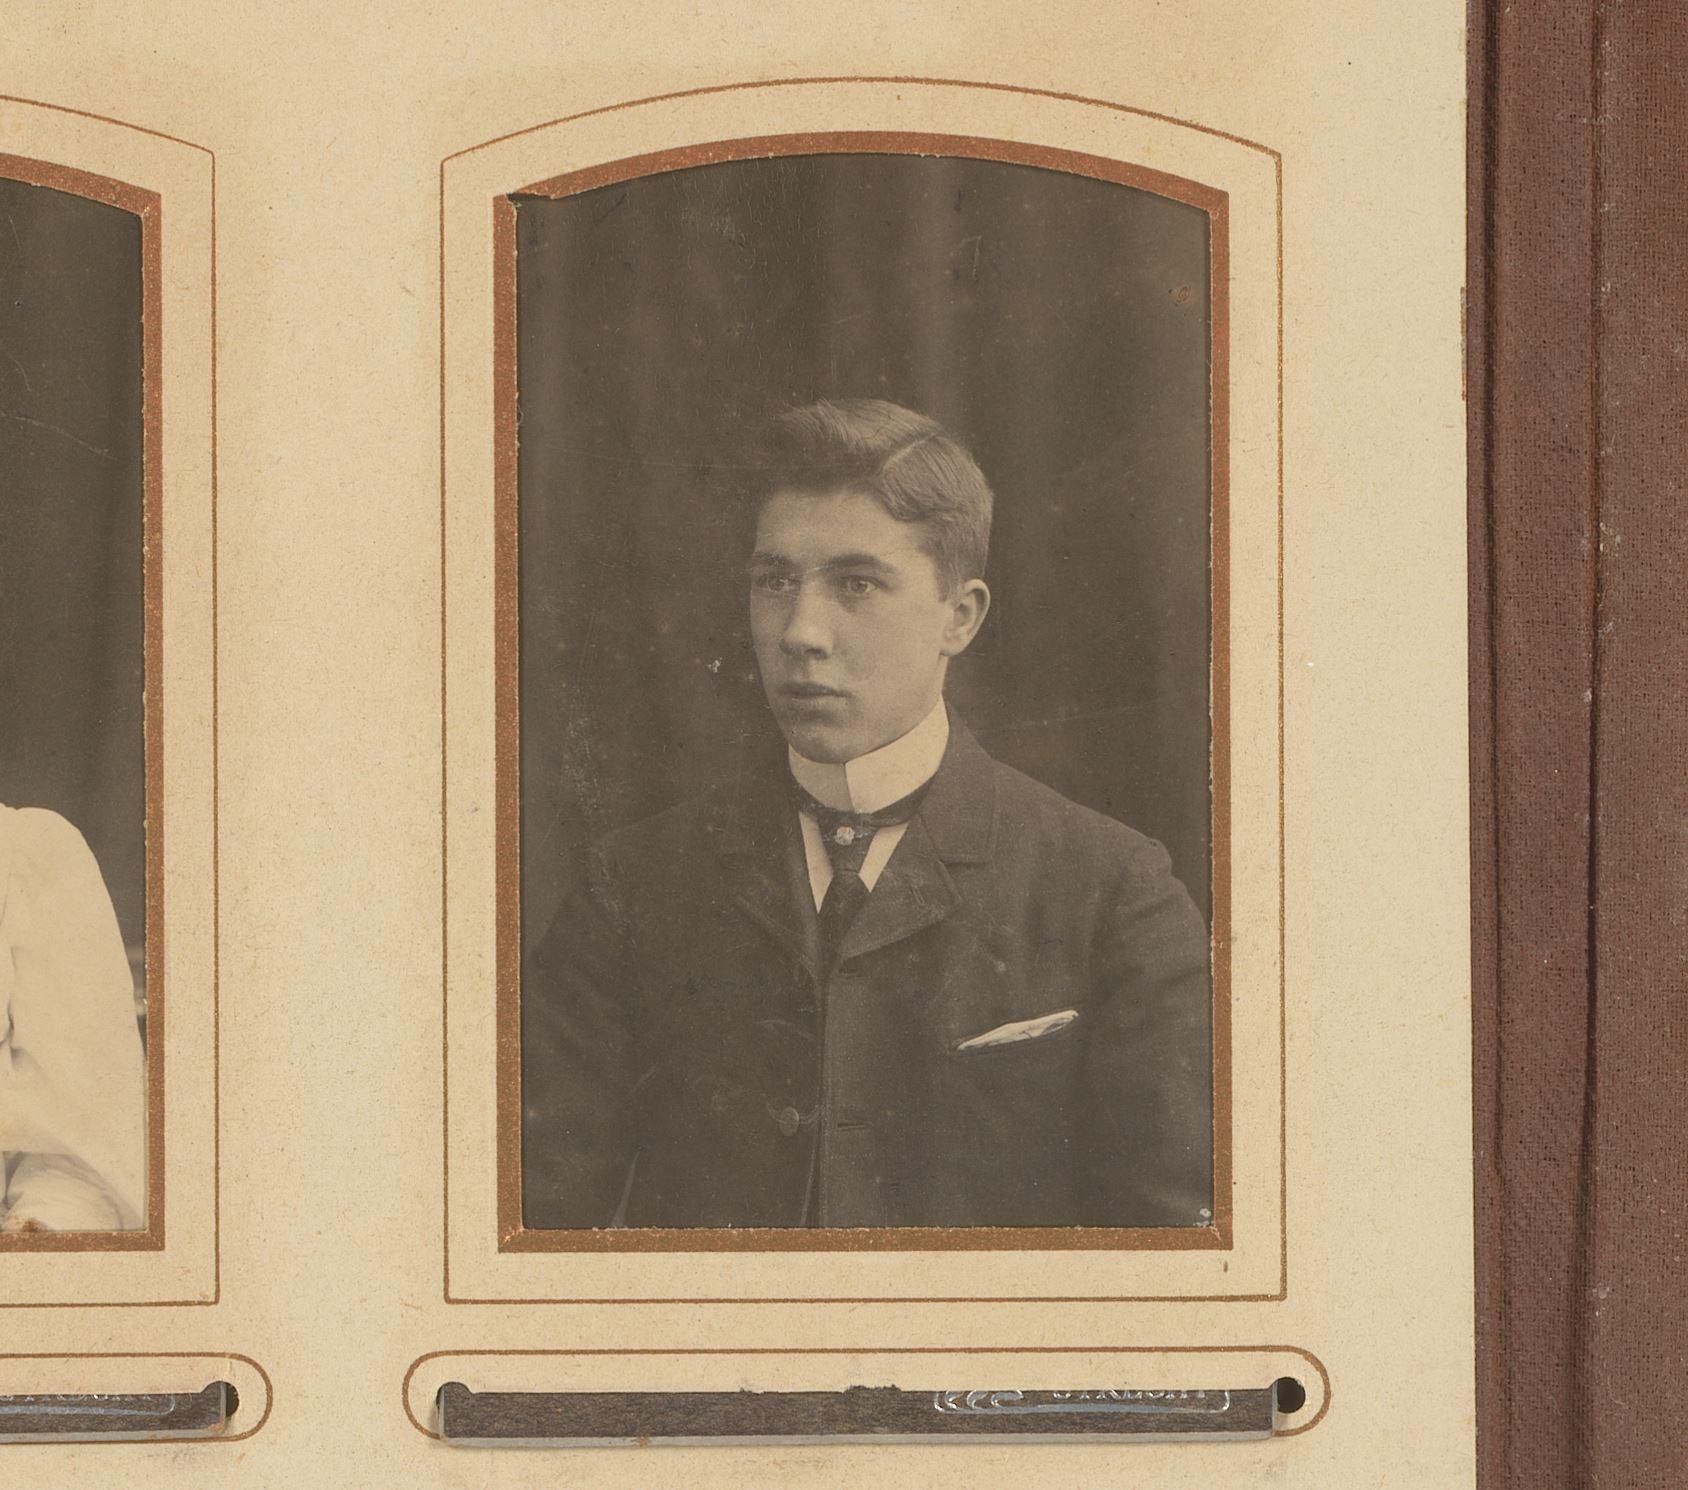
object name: carte de visite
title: Portret van een jongeman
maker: anton cornelis thomann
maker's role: fotograaf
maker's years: 1873-1946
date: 1894-1920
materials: cardboard, photographic support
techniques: collodion silver print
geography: utrecht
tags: historical persons, youth, adolescent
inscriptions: inscription: ‘Anton C. Thomann/ Photograaf/ Utrecht’